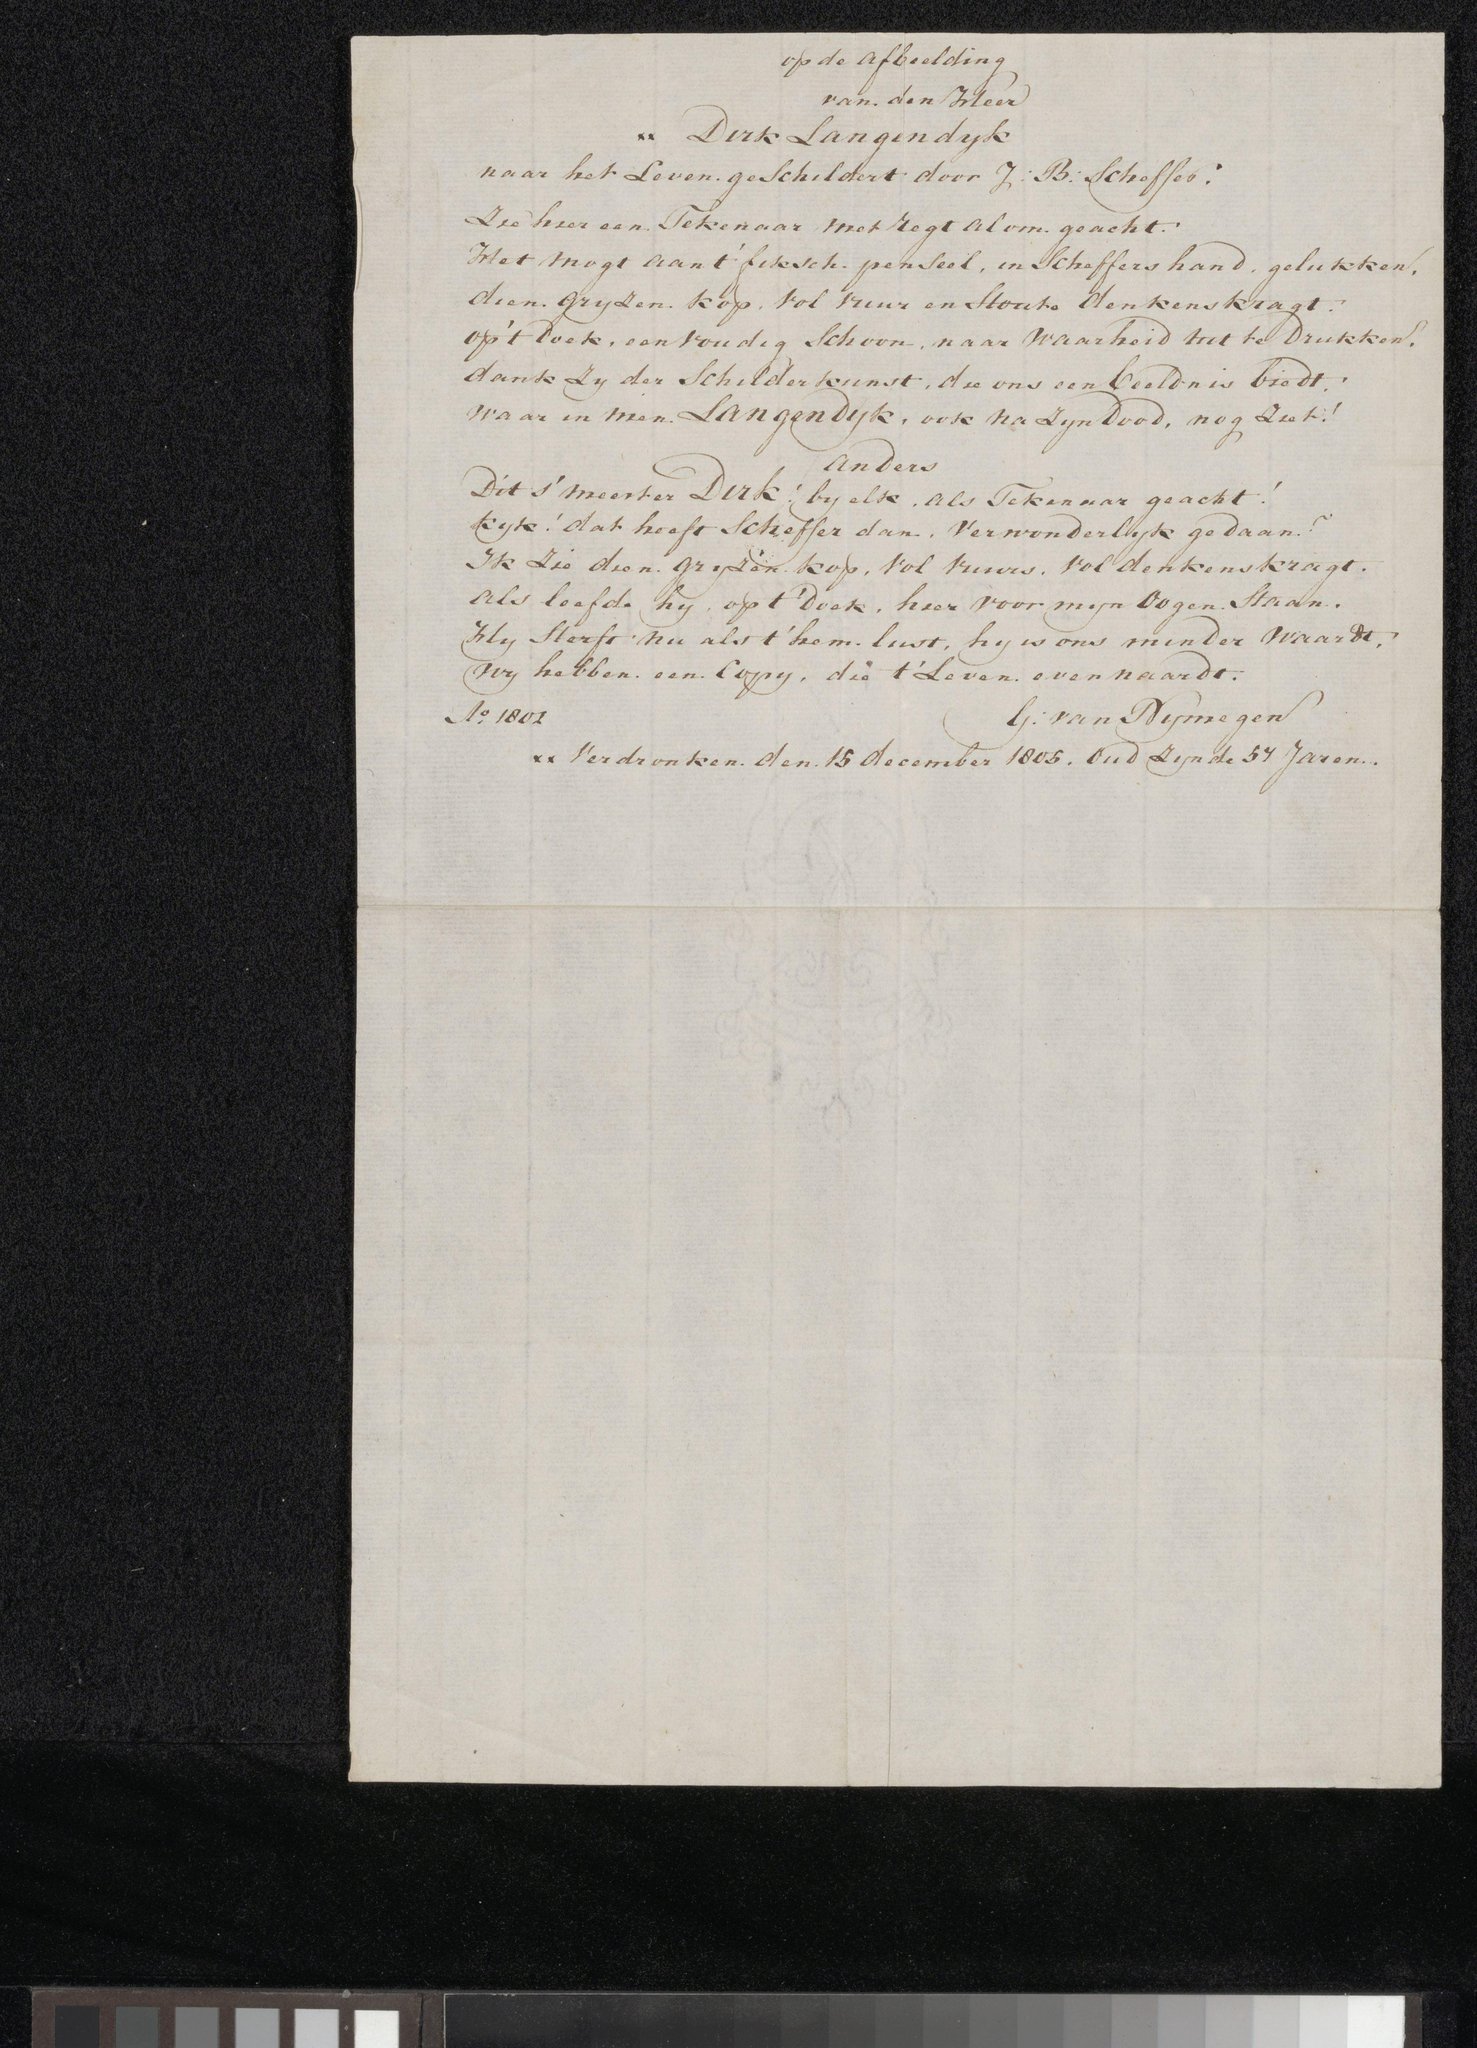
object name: poem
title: Gedicht op het portret van Dirk Langendijk door J.B. Scheffer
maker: gerard van nijmegen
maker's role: draughtsman, painter, print maker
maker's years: 1735-1808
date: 1805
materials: ink, paper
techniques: pen, writing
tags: dirk langendijk, johan bernard scheffer, drawing, painting (including book-illumination, miniature-painting), historical persons (portraits and scenes from the life)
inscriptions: watermark